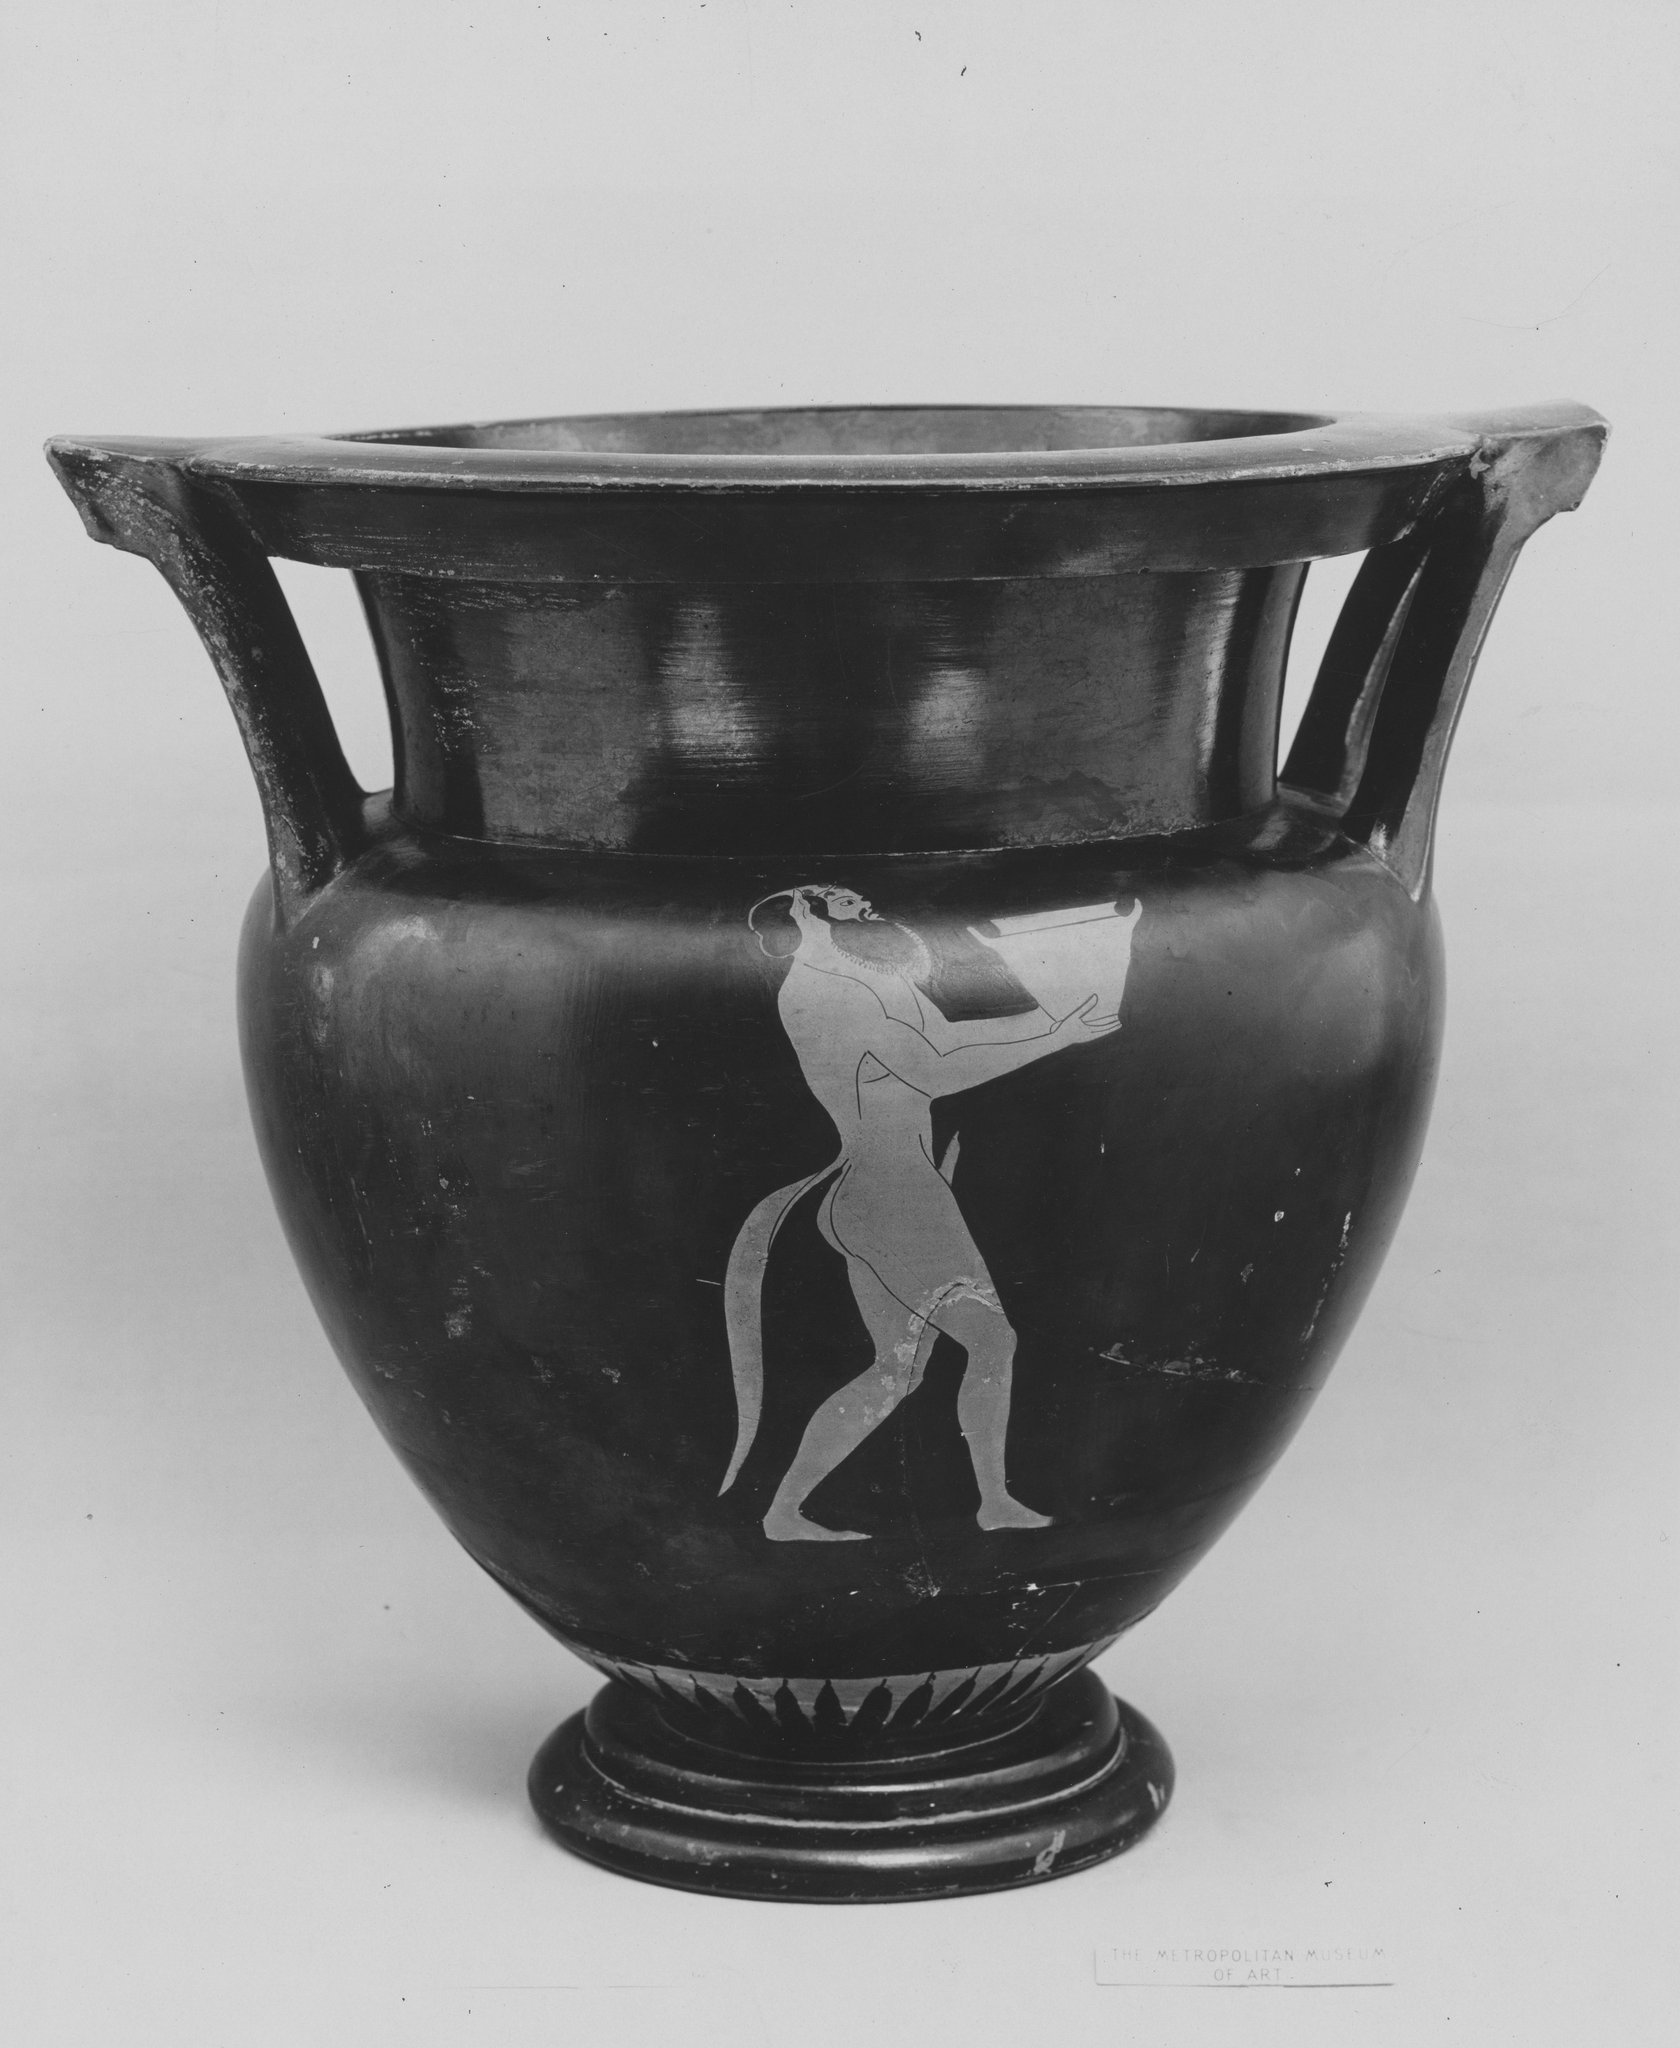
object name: column krater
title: Terracotta column-krater (bowl for mixing wine and water)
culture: greek, attic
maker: pan painter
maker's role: artist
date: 470-460 BCE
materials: terracotta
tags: dionysus,satyrs